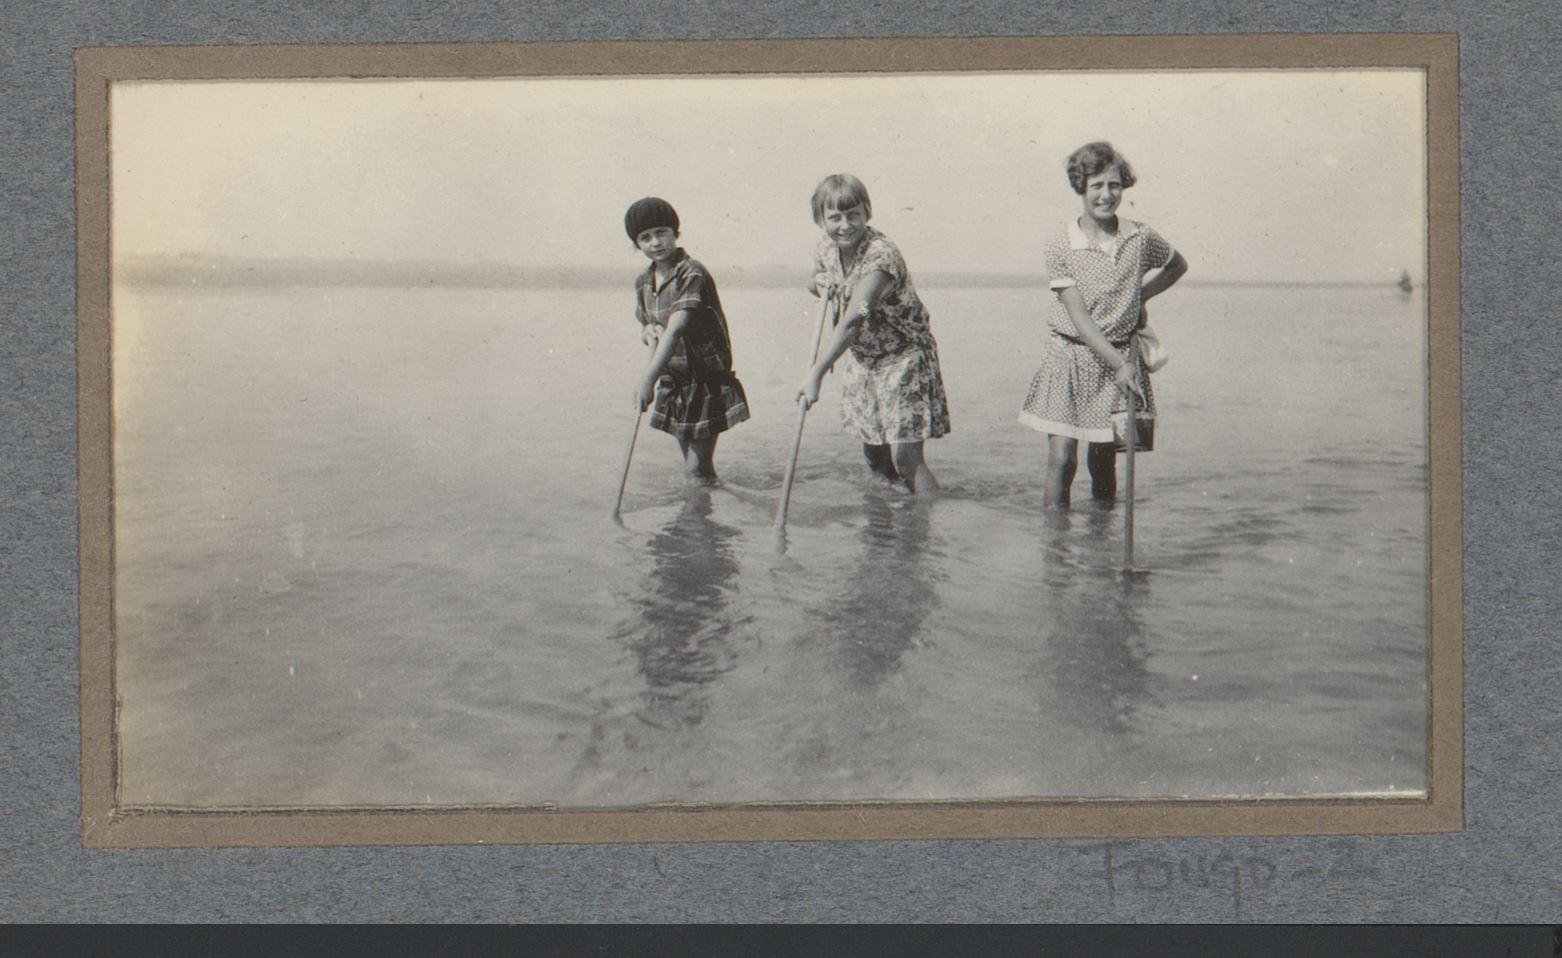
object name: album leaf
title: Drie kinderen in het water met stokken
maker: Anonymous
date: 1926-1932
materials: photographic support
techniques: gelatin silver print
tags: child, lake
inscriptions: inscription: ‘Opnamen gemaakt met de Zak-"Kodak"No. 1a./ Afdrukken gemaakt op "Velox" papier.’